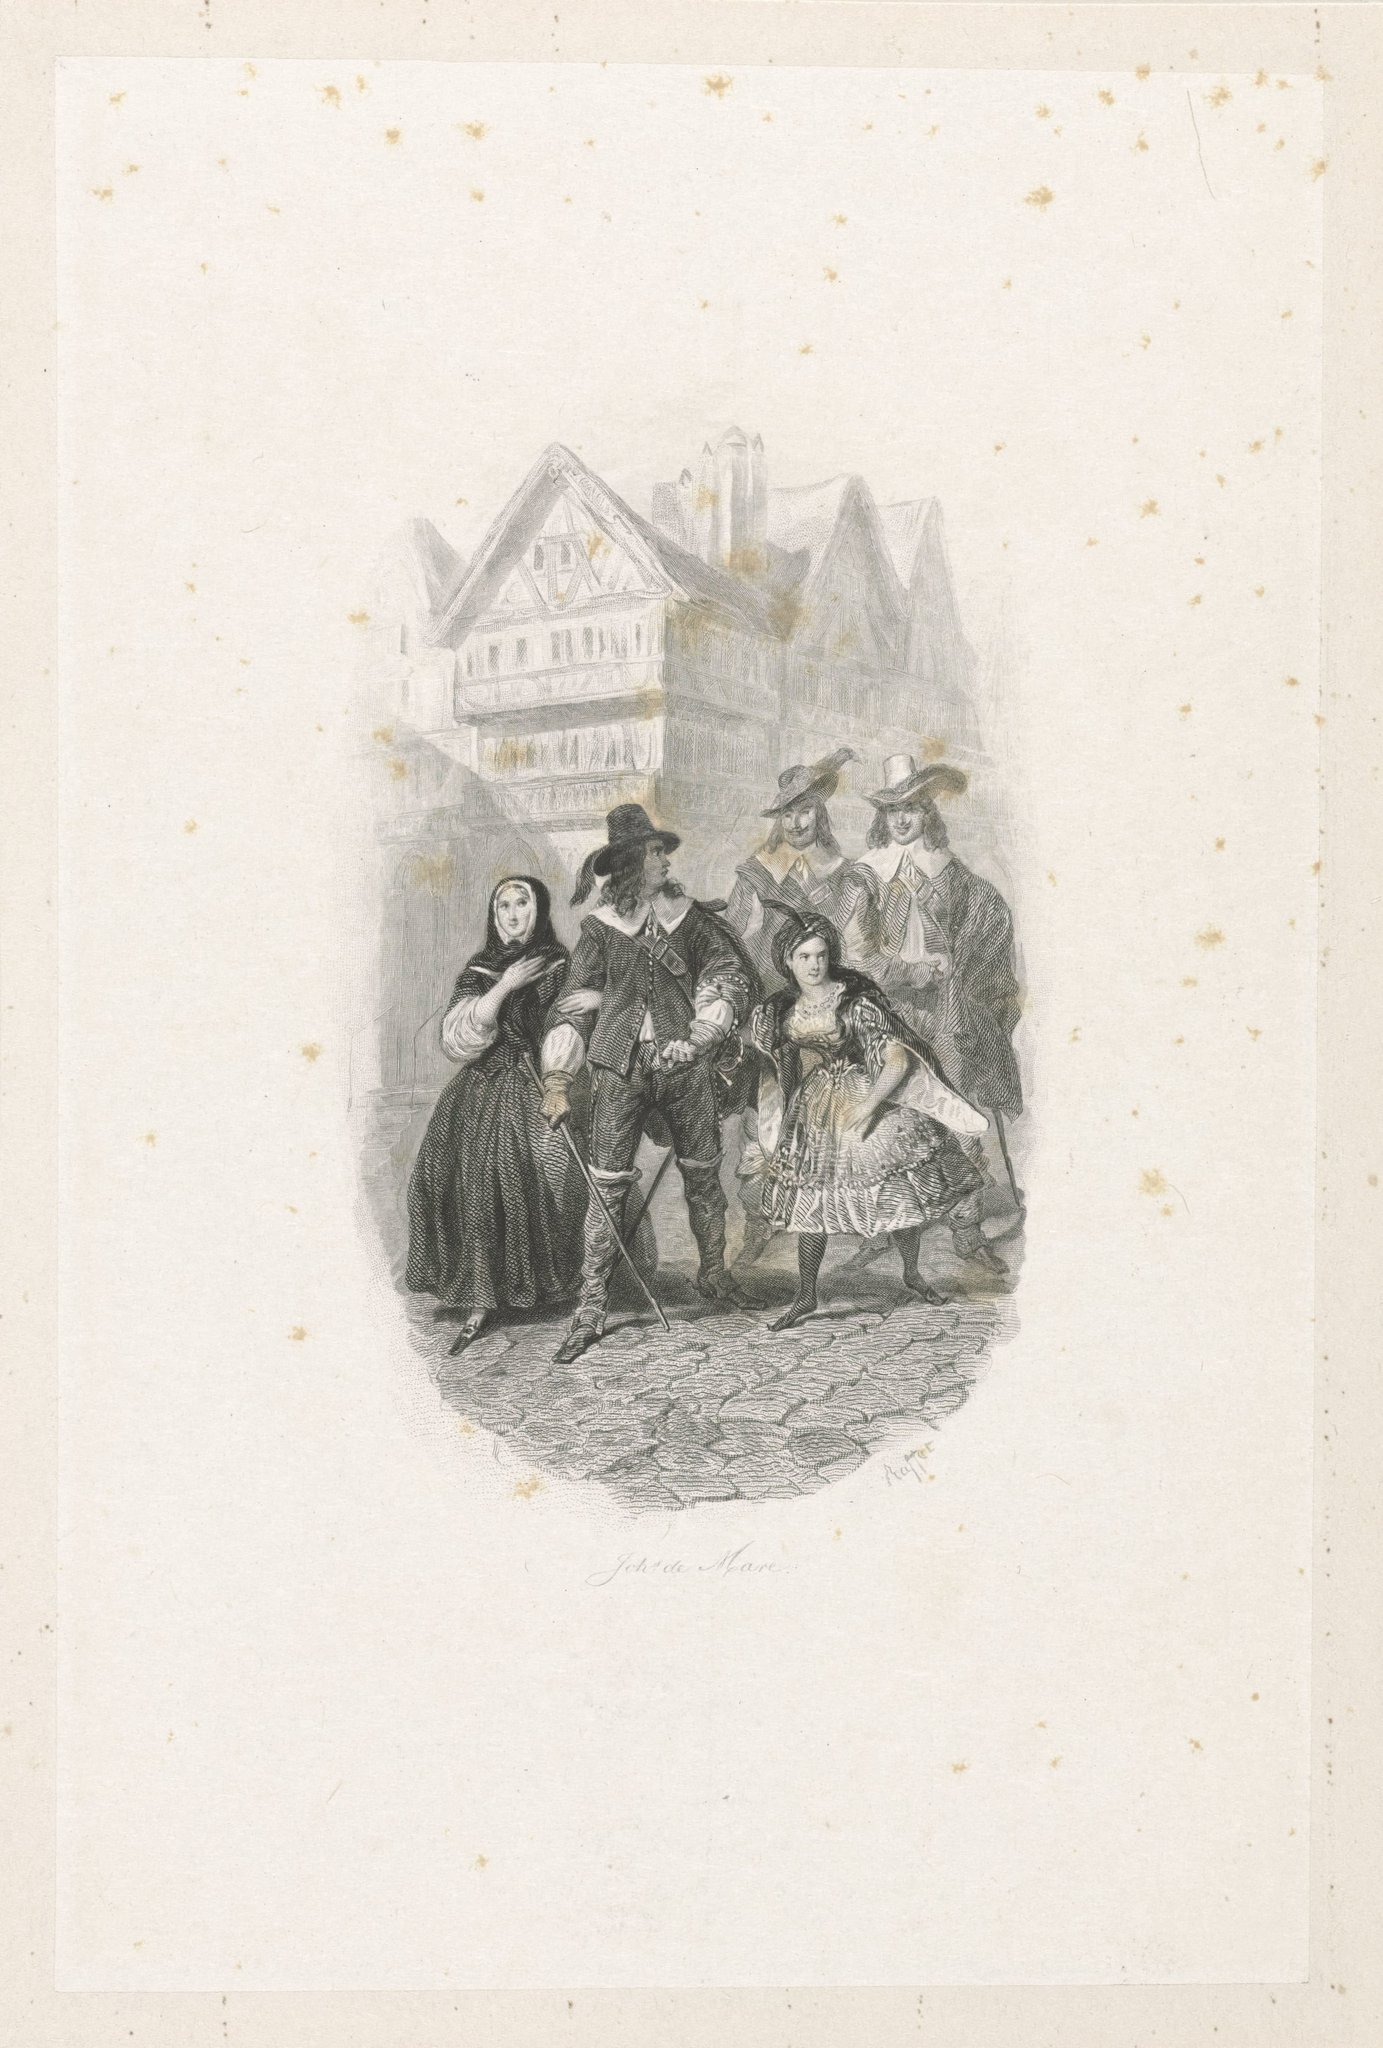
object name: print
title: Gearmd gezelschap en twee mannen in een straat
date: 1816-1889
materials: paper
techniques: engraving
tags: public road in village, aggressive relationships, enmity, animosity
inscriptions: collector's mark: Lugt 2228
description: In een straat loopt een man met aan zijn ene arm een vrouw en aan zijn andere een meisje. Hij kijkt om over zijn schouder naar twee mannen. Huizen met vakwerk op de achtergrond.